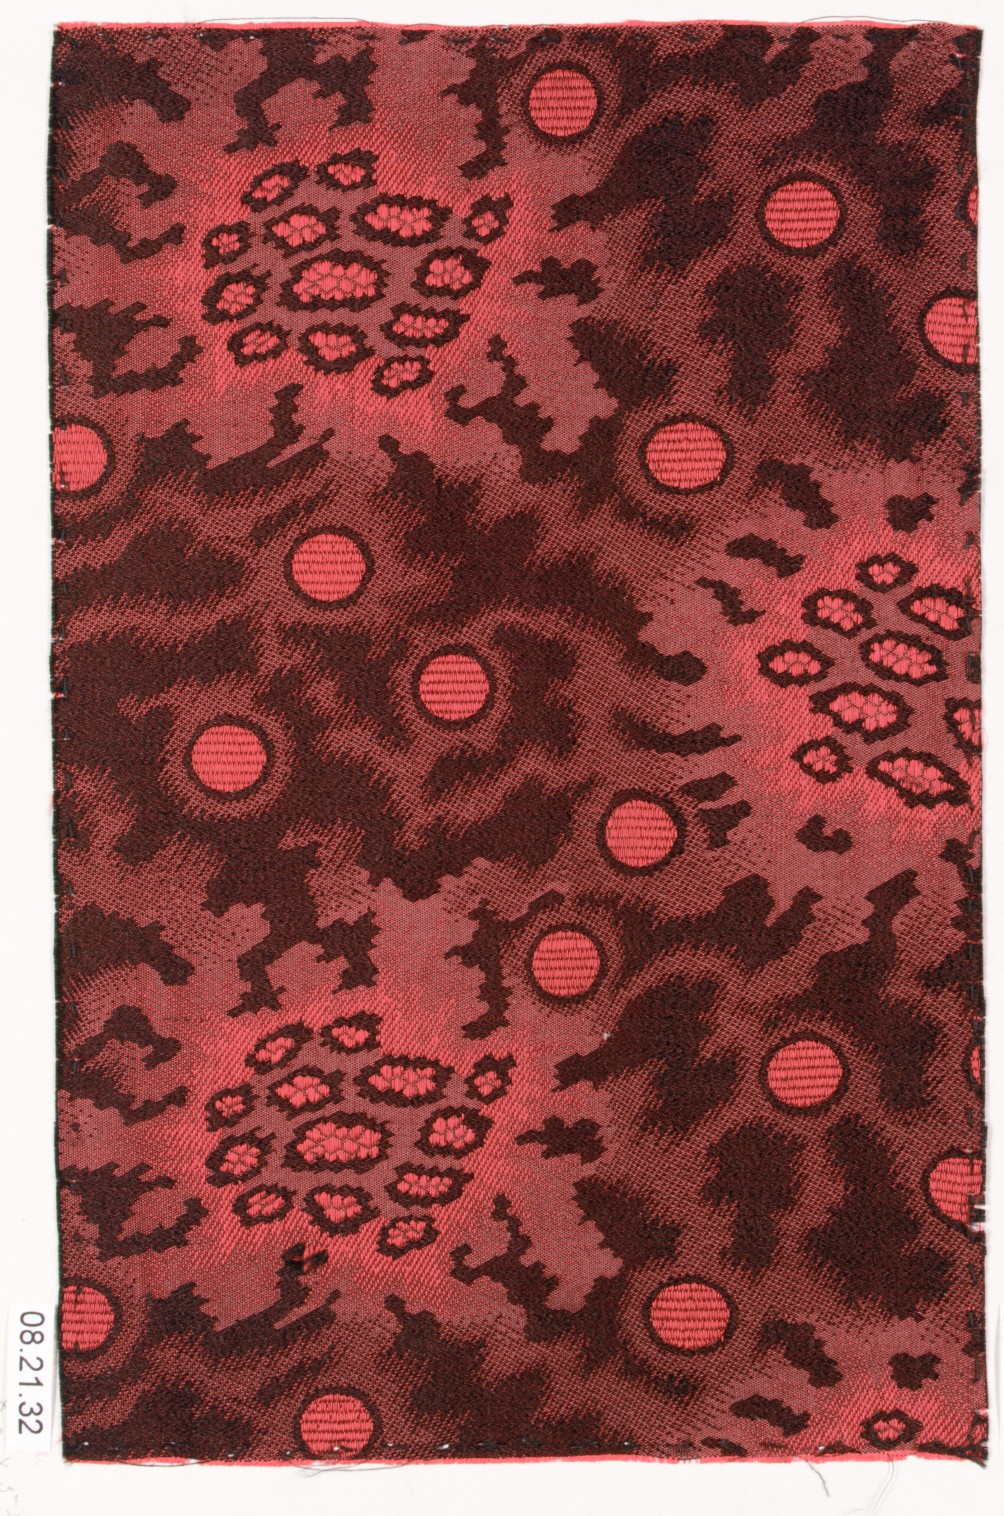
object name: textile sample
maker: Anonymous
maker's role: designer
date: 1900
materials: silk